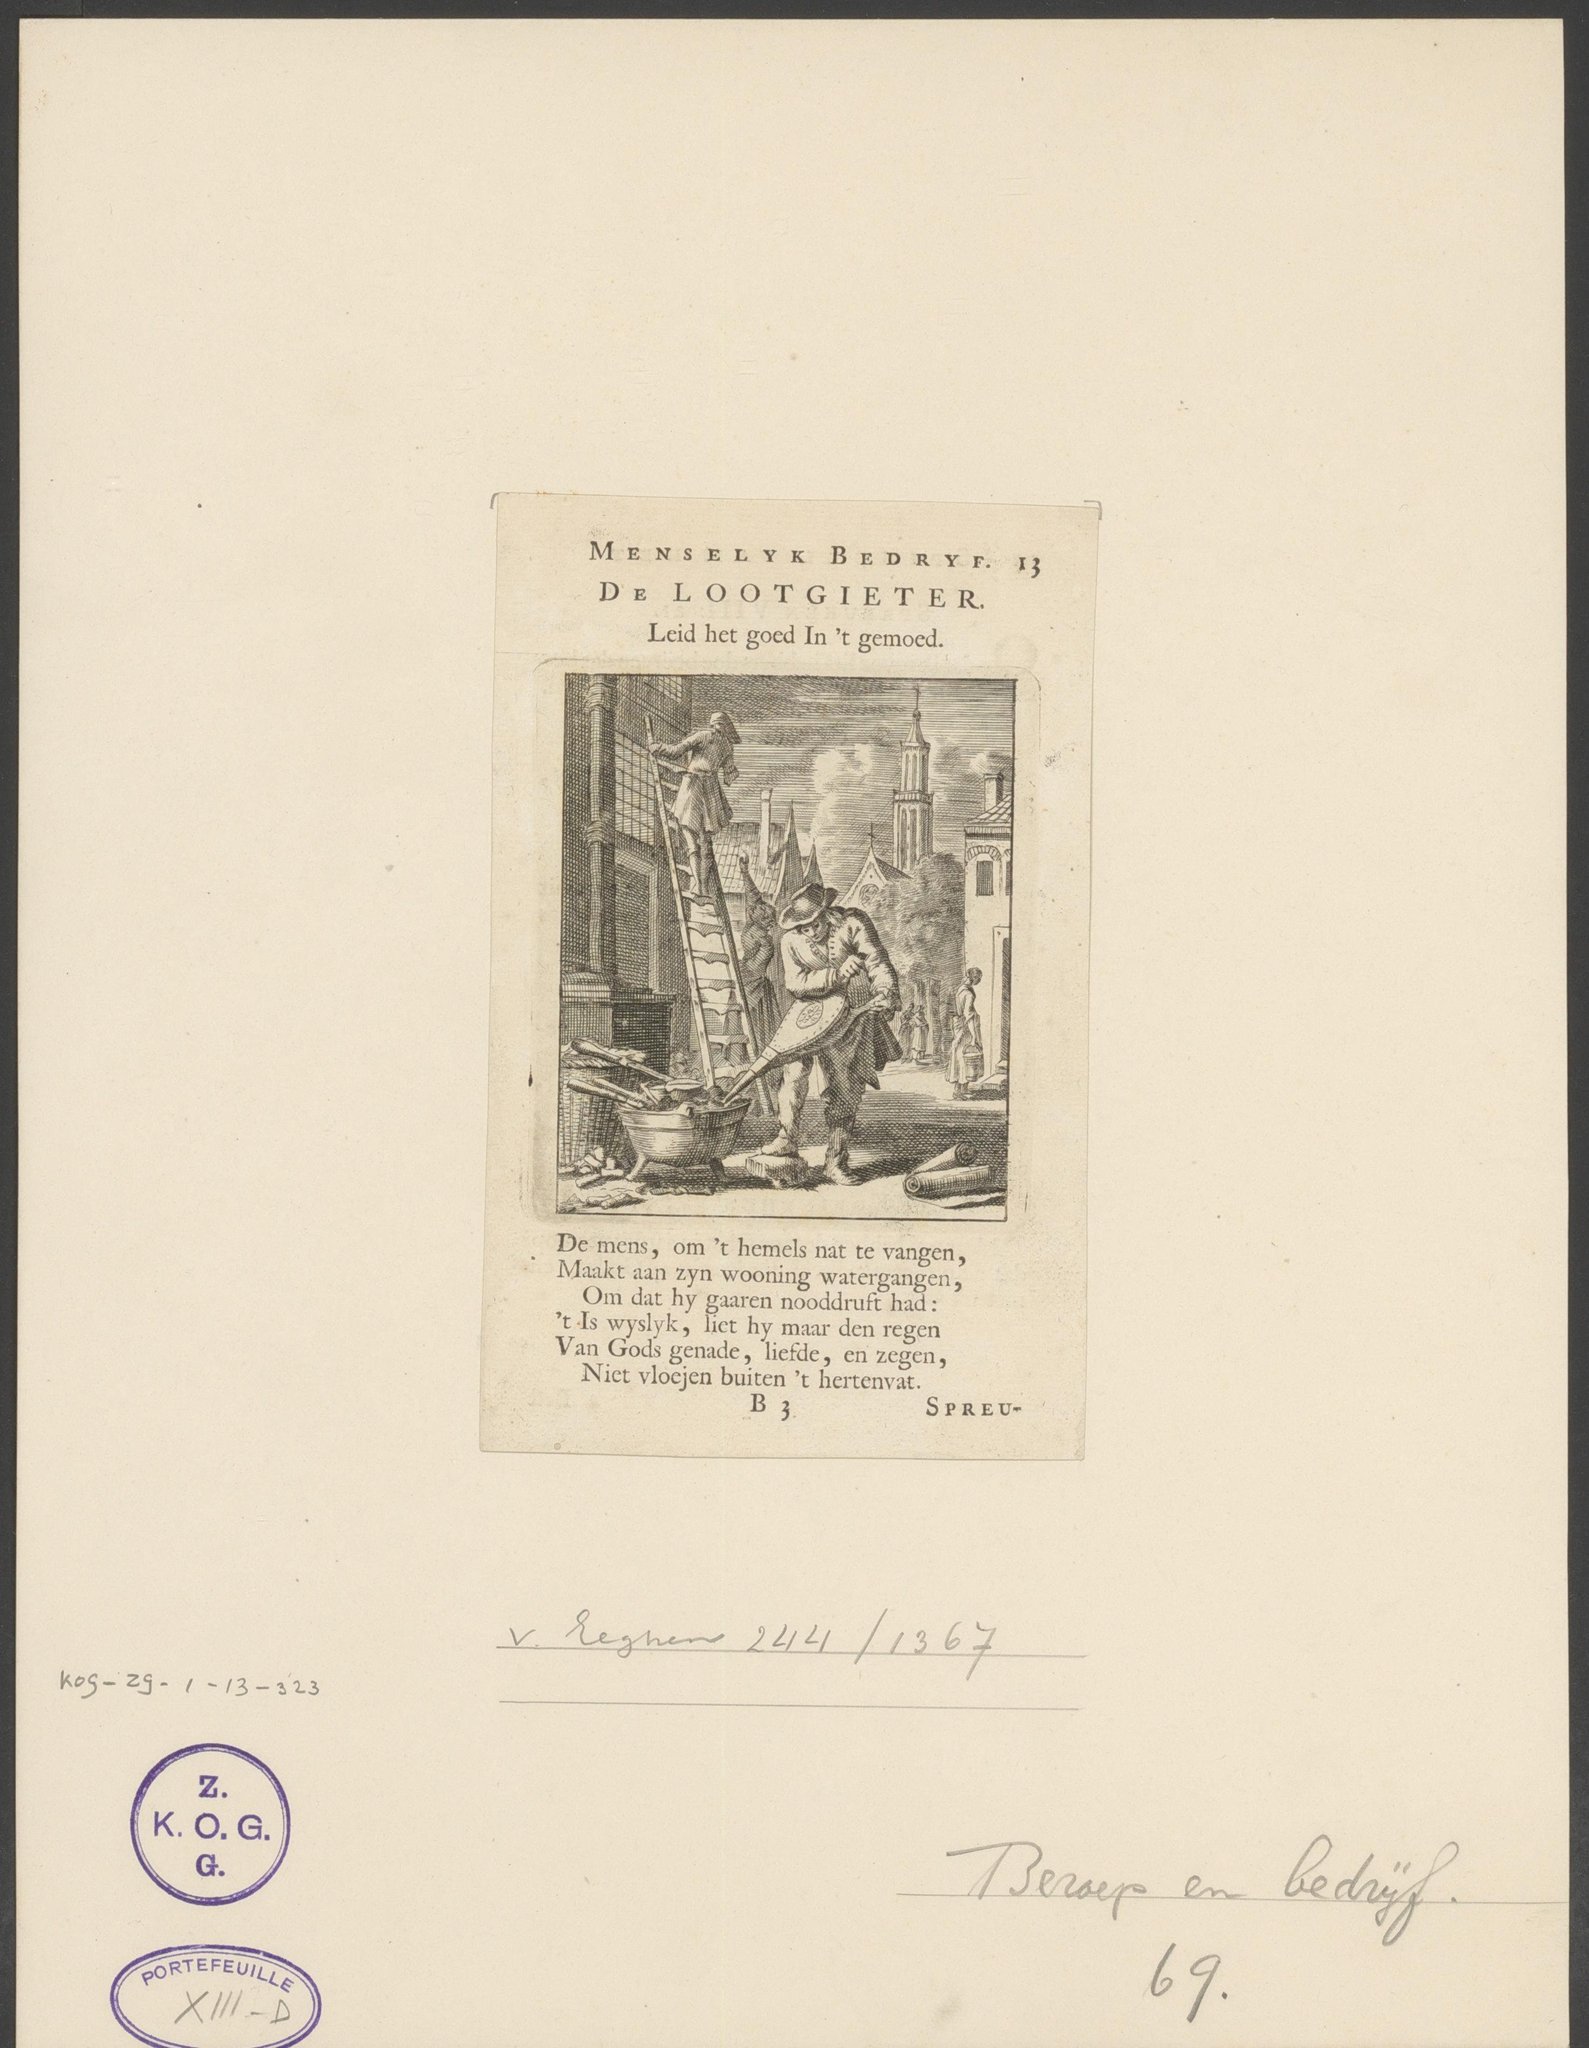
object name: book illustration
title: De Lootgieter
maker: cornelis van der sys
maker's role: publisher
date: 1718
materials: paper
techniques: etching, letterpress printing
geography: amsterdam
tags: plumber, handicrafts, craftsman at work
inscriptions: stamp, collector's mark: Lugt 1641, stamp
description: Prent oorspronkelijk verschenen in de 100-delige serie beroepsprenten van Jan en Caspar Luyken, getiteld: Het menselyk bedryf. S.l.s.n., 1694 (eerste druk). Daarna is de titel en het vers afgesneden. De prenten in diverse publicaties verschenen en gekopieerd. Huidige staat uit: Luyken, Jan en Caspar. Spiegel van het menselyk bedryf (...). Amsterdam: Cornelis van der Sys, 1718, p. 13. Prent waarschijnlijk ook gebruikt in eerdere (1704) en latere (1730, 1749, 1767) publicaties.